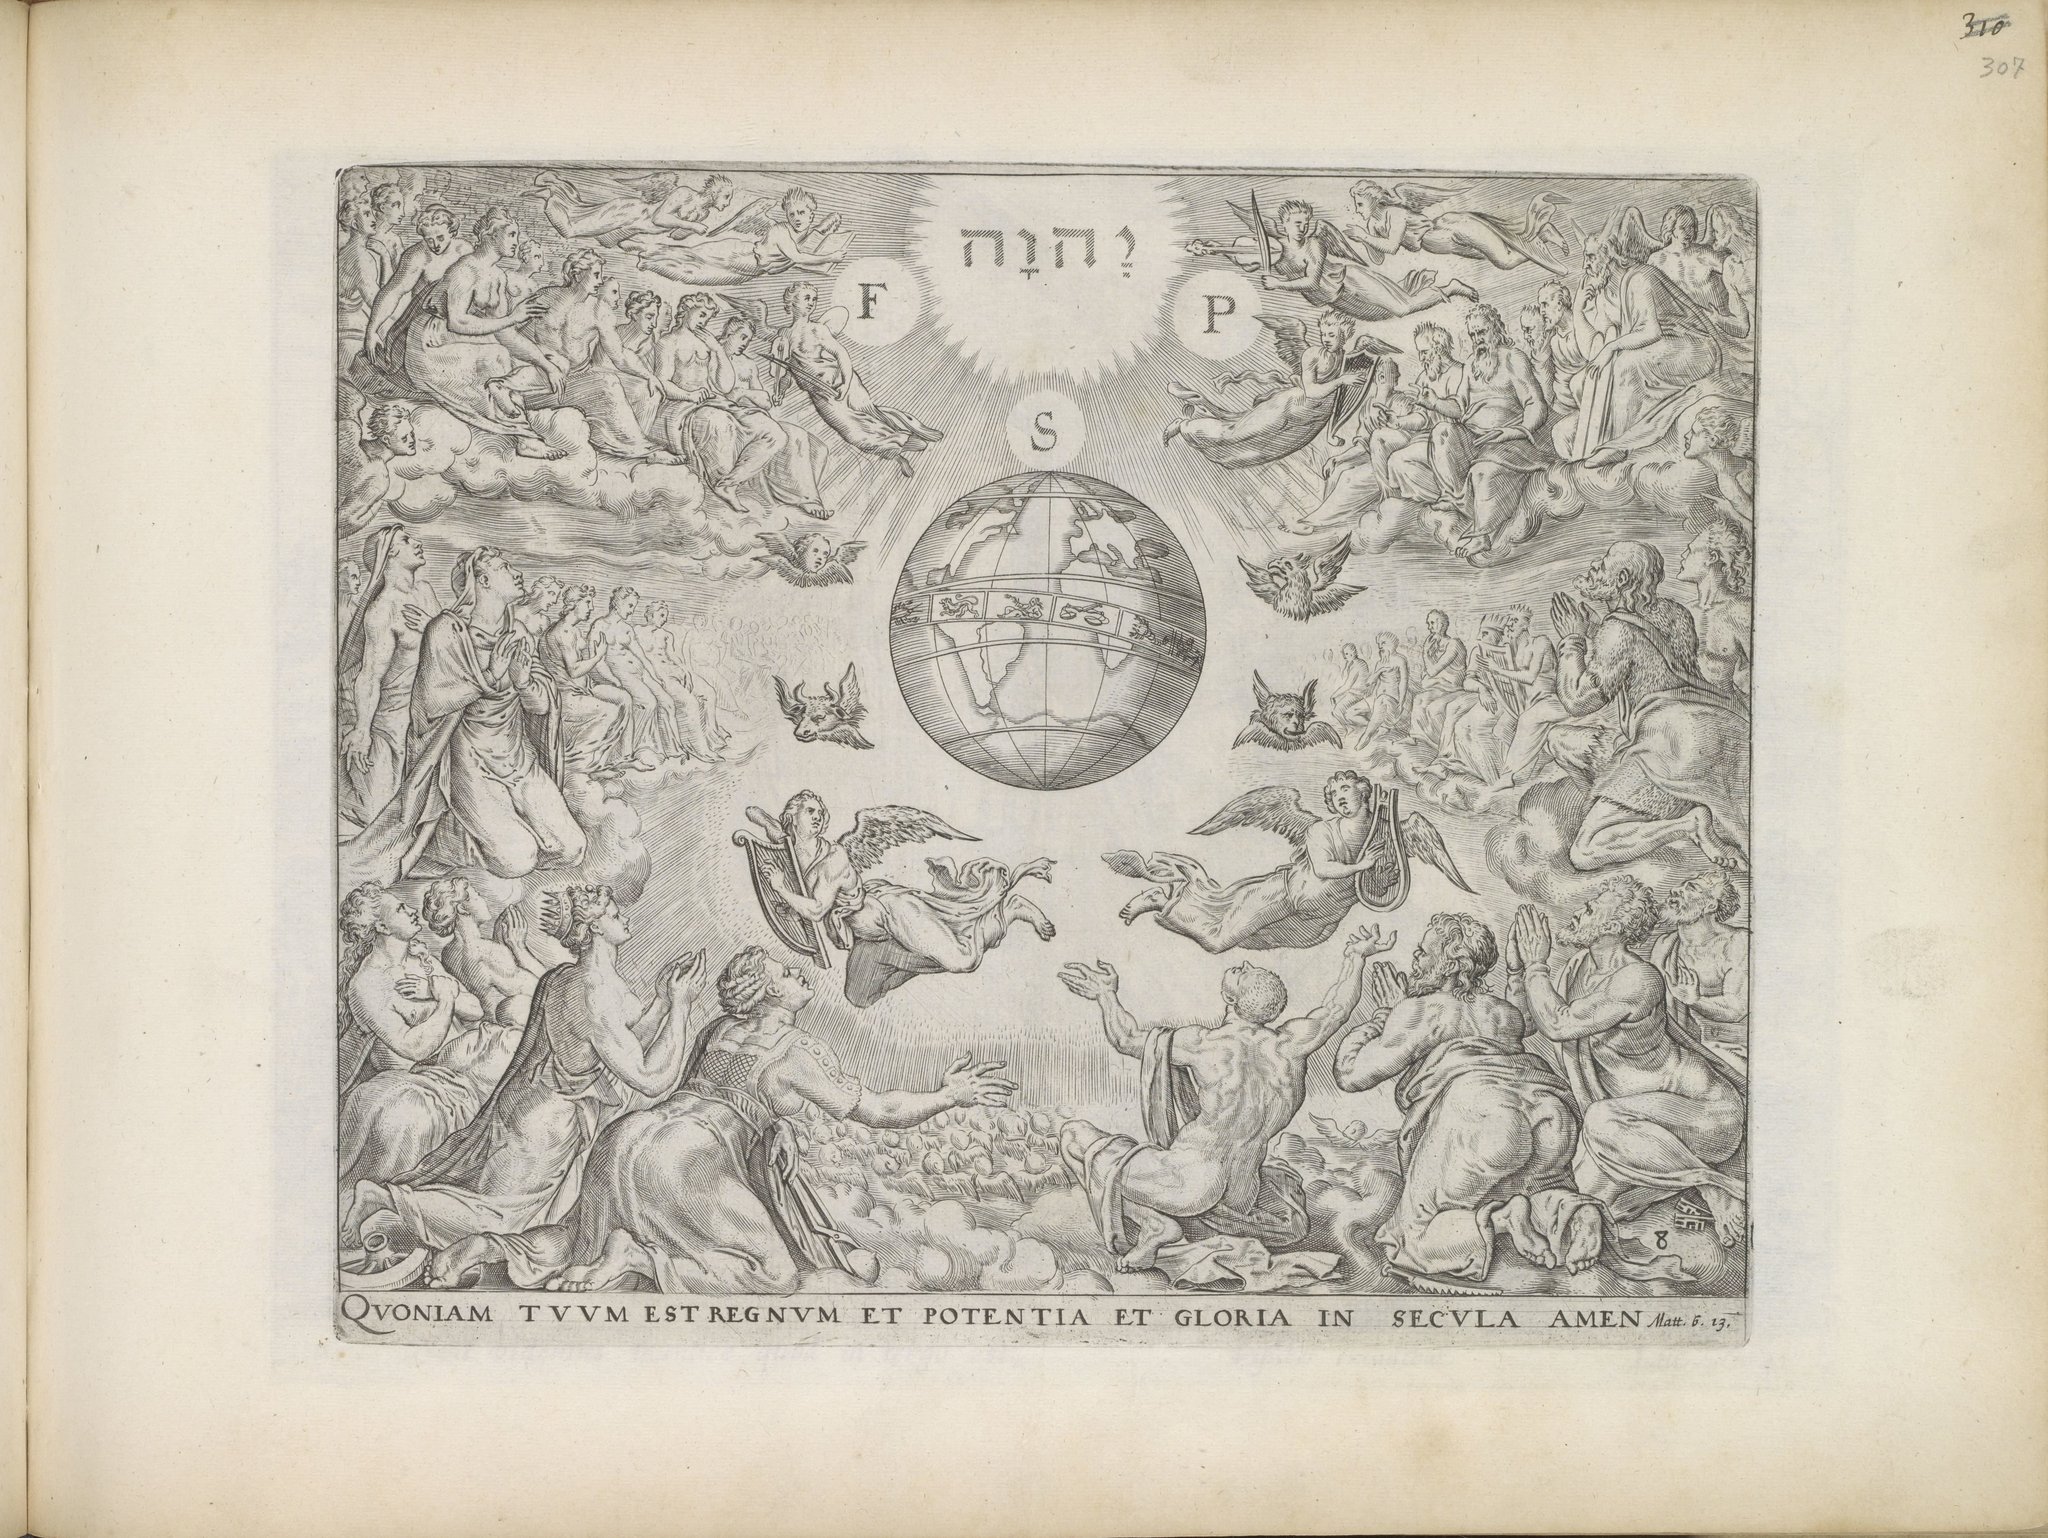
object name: album leaf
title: Theatrum Biblicum Hoc Est Historiae Sacrae Veteris et Novi Testamenti Tabulis Aeneis Expressae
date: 1569-1573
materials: paper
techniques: engraving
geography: amsterdam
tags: god the father holding the crucified or dead christ (+ angels floating in the air), 'for thine is the kingdom' ~ the lord's prayer, 'and the power' ~ the lord's prayer, 'and the glory, for ever' ~ the lord's prayer, the four symbols of the evangelists, 'the apocalyptic beasts'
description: Illustratie van de laatste regel van het Onze Vader gebed: Want van U is het Koninkrijk en de kracht en de heerlijkheid tot in de eeuwigheid. De Drieëenheid wordt aanbeden door mensen en engelen. God de Vader zit op een globe met zijn gekruisigde zoon Christus op schoot. Boven hen de duif van de Heilige Geest. Rond de globe de symbolen van de vier evangelisten (de apocalyptische dieren) en musicerende engelen. Onder de voorstelling dit gedeelte van het Onze Vader in het Latijn en een verwijzing naar de Bijbeltekst in Mat. 6:13. Deze prent maakt deel uit van een album.